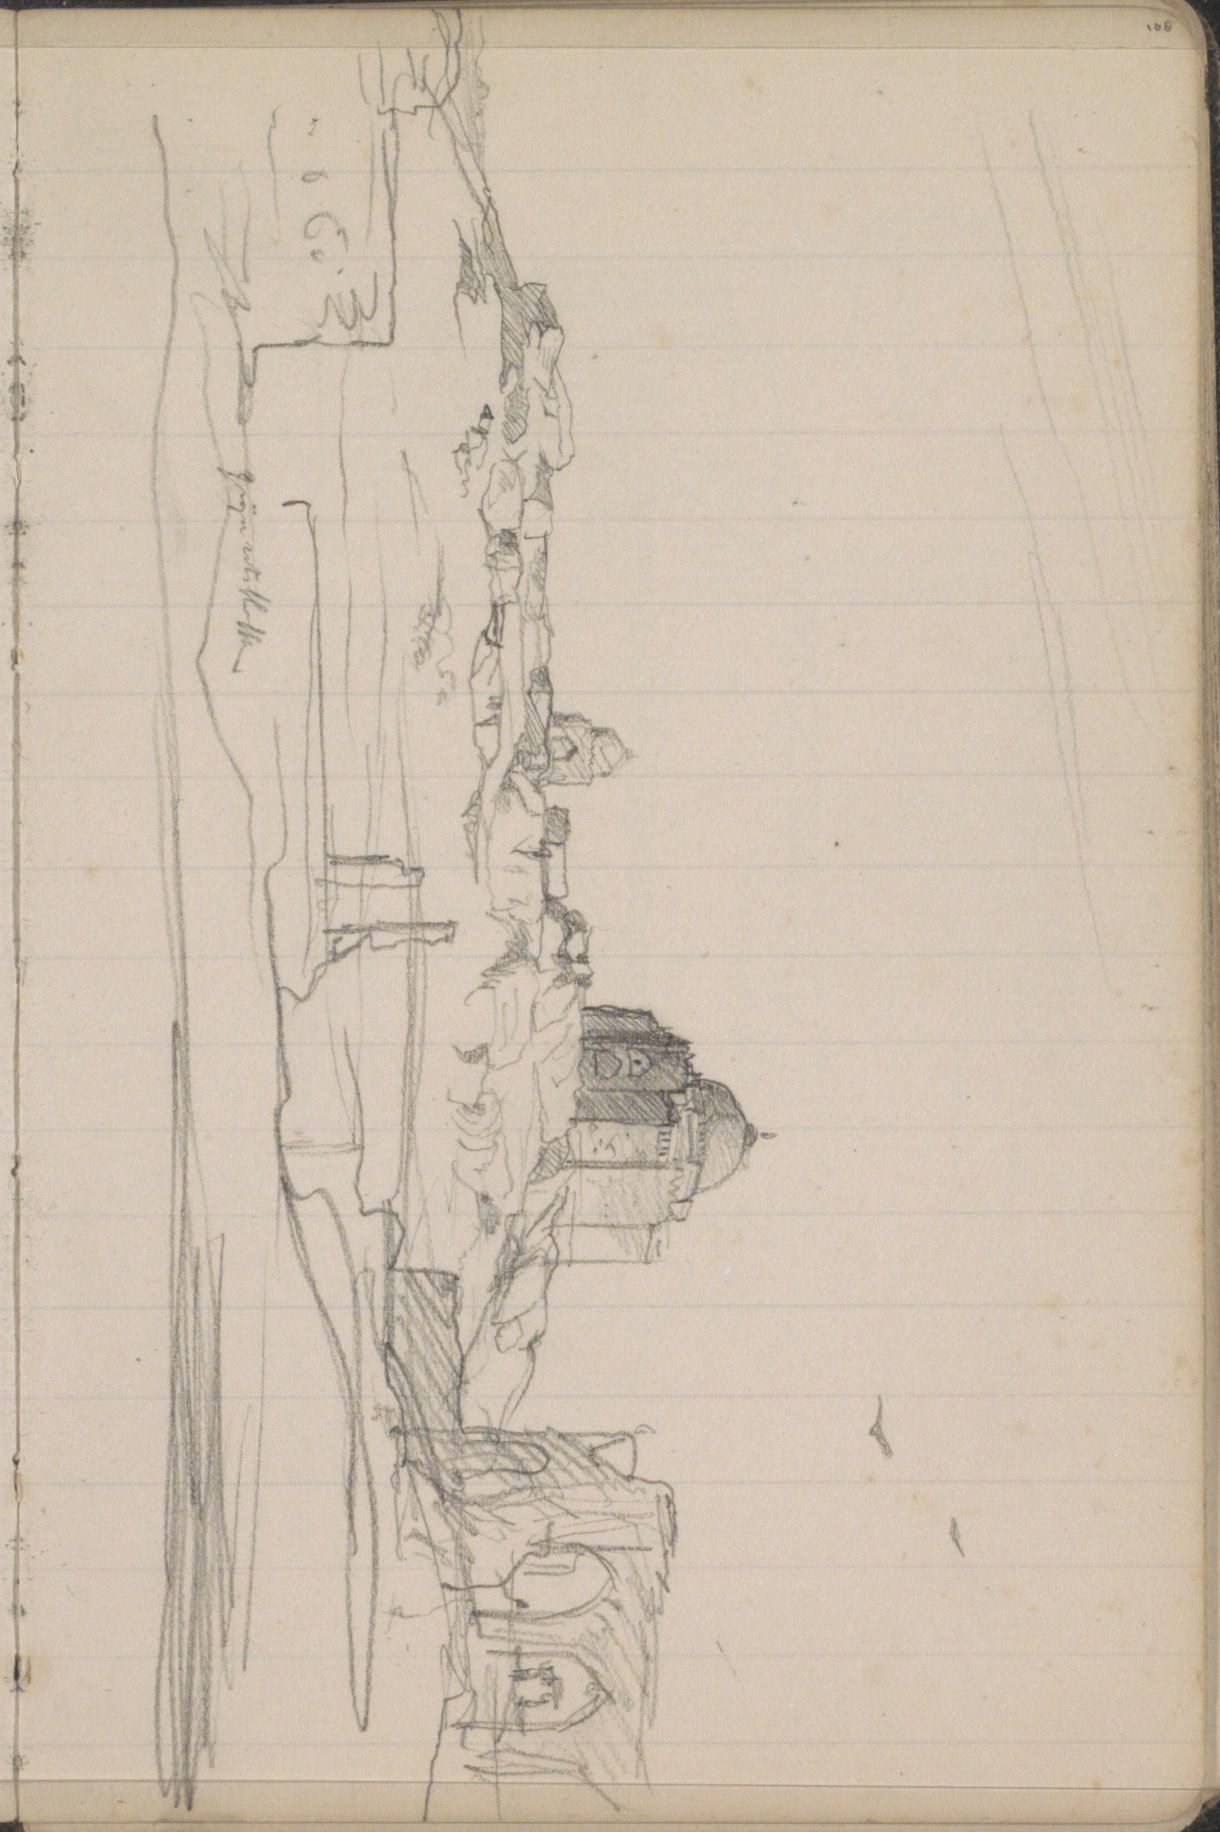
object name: sketchbook leaf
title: Landschap met een moskee en ruïne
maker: marius bauer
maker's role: draughtsman, print maker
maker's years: 1867-1932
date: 1897-1898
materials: pencil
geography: delhi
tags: city-view, and landscape with man-made constructions, landscape with ruins, temple, shrine ~ islam, mohammedanism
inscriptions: kleurnotitie, handgeschreven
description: Vermoedelijk één van de ruïnes van Qutub. Pagina 108 uit een schetsboek met 84 bladen.